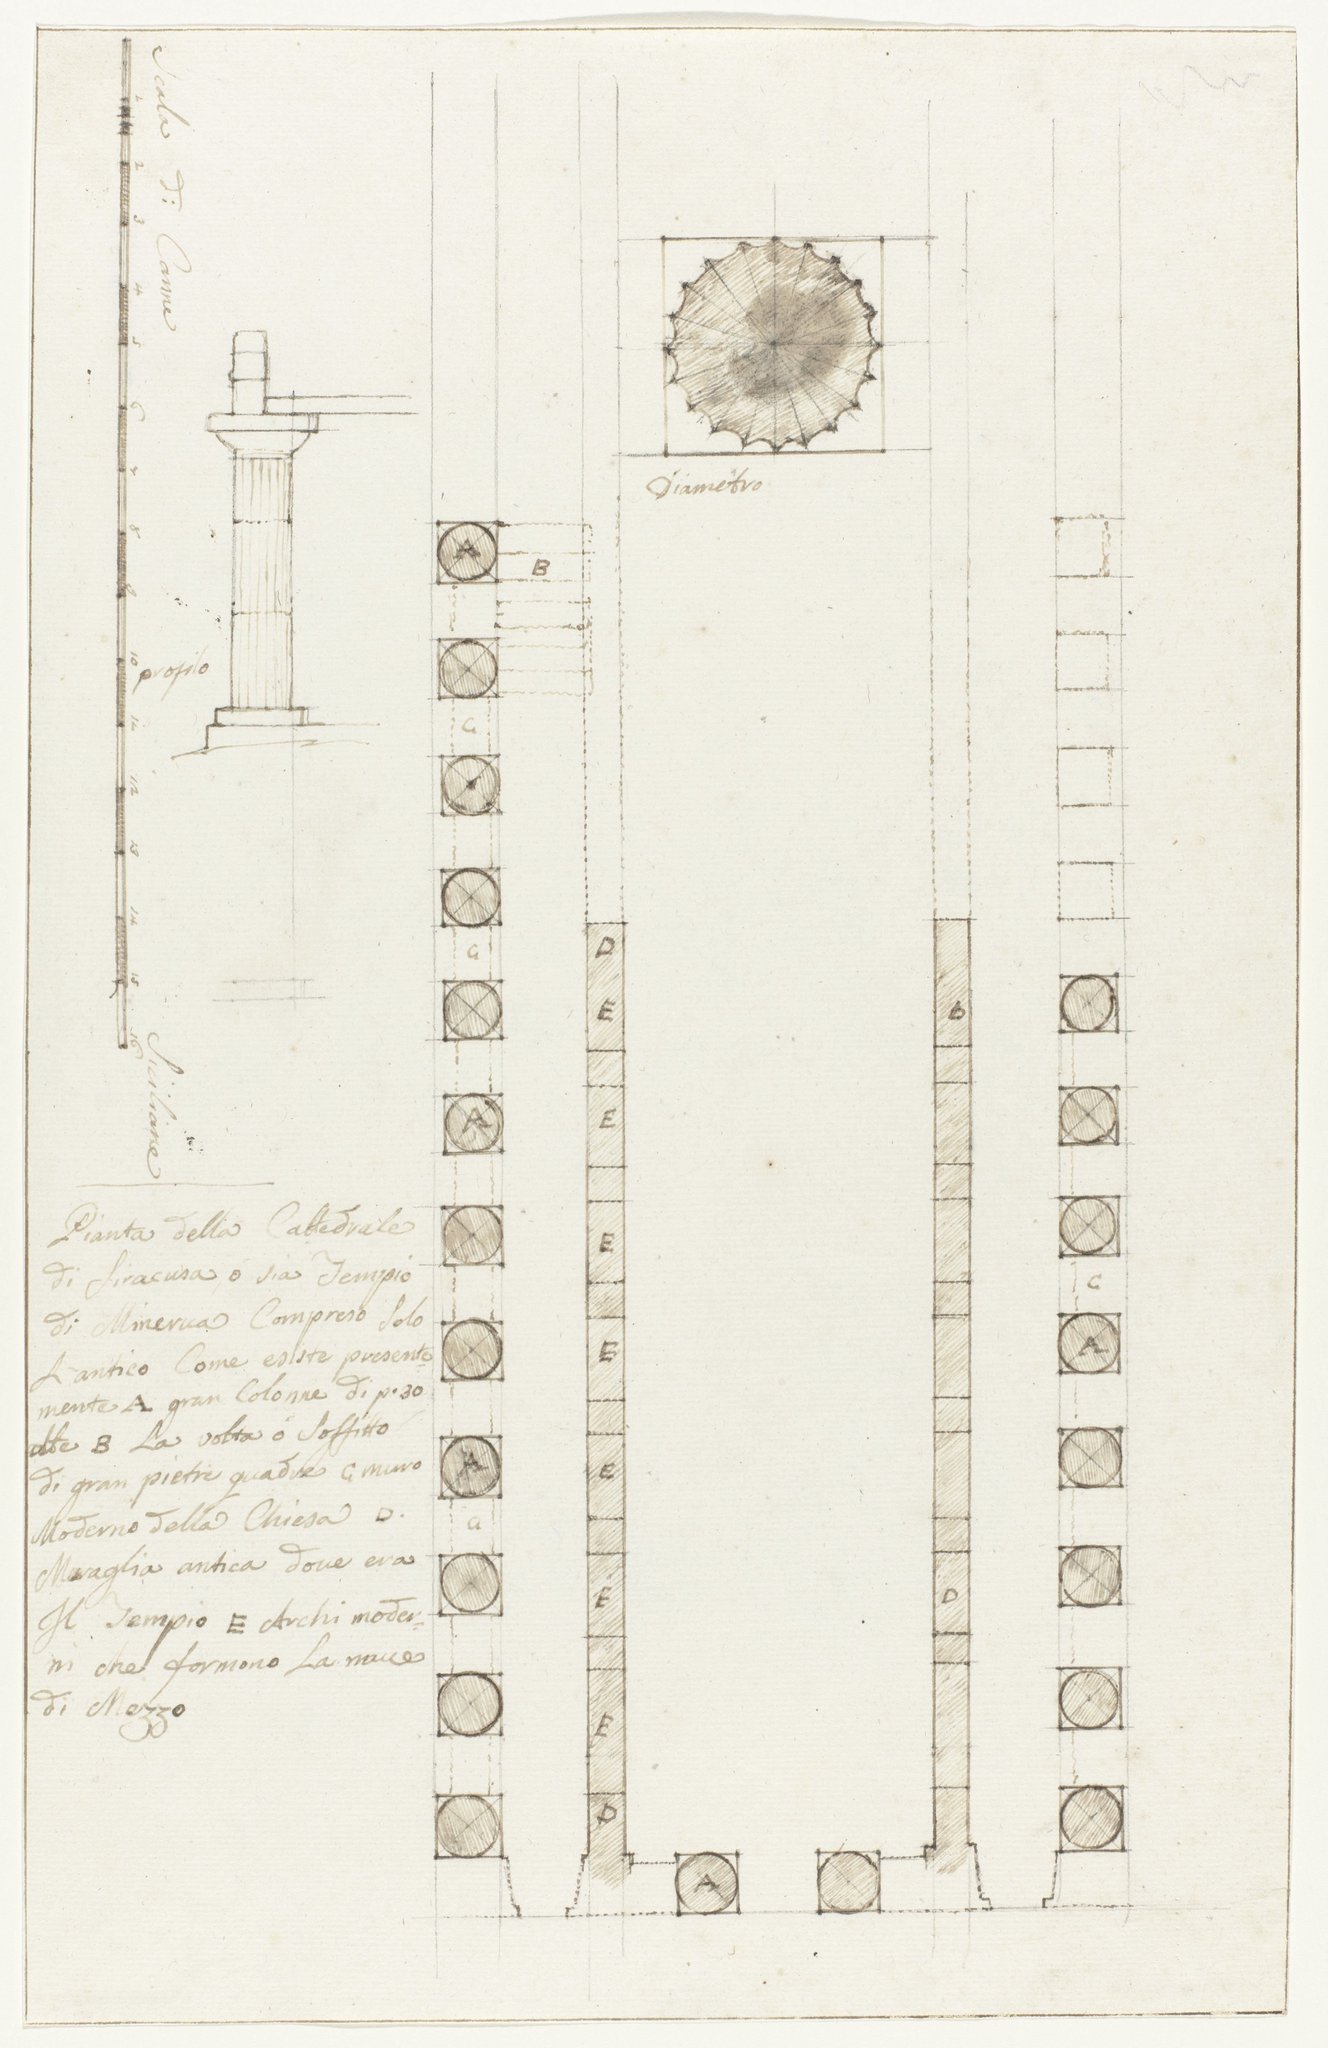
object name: drawing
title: Voyage en Italie, en Sicile et à Malte - 1778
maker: louis mayer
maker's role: draughtsman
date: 1778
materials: paper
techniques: pen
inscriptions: inscription: ‘Pianta della cathedrale ... La m[...] di mezzo’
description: Tekening uit het album 'Voyage en Italie, en Sicile et à Malte', 1778.